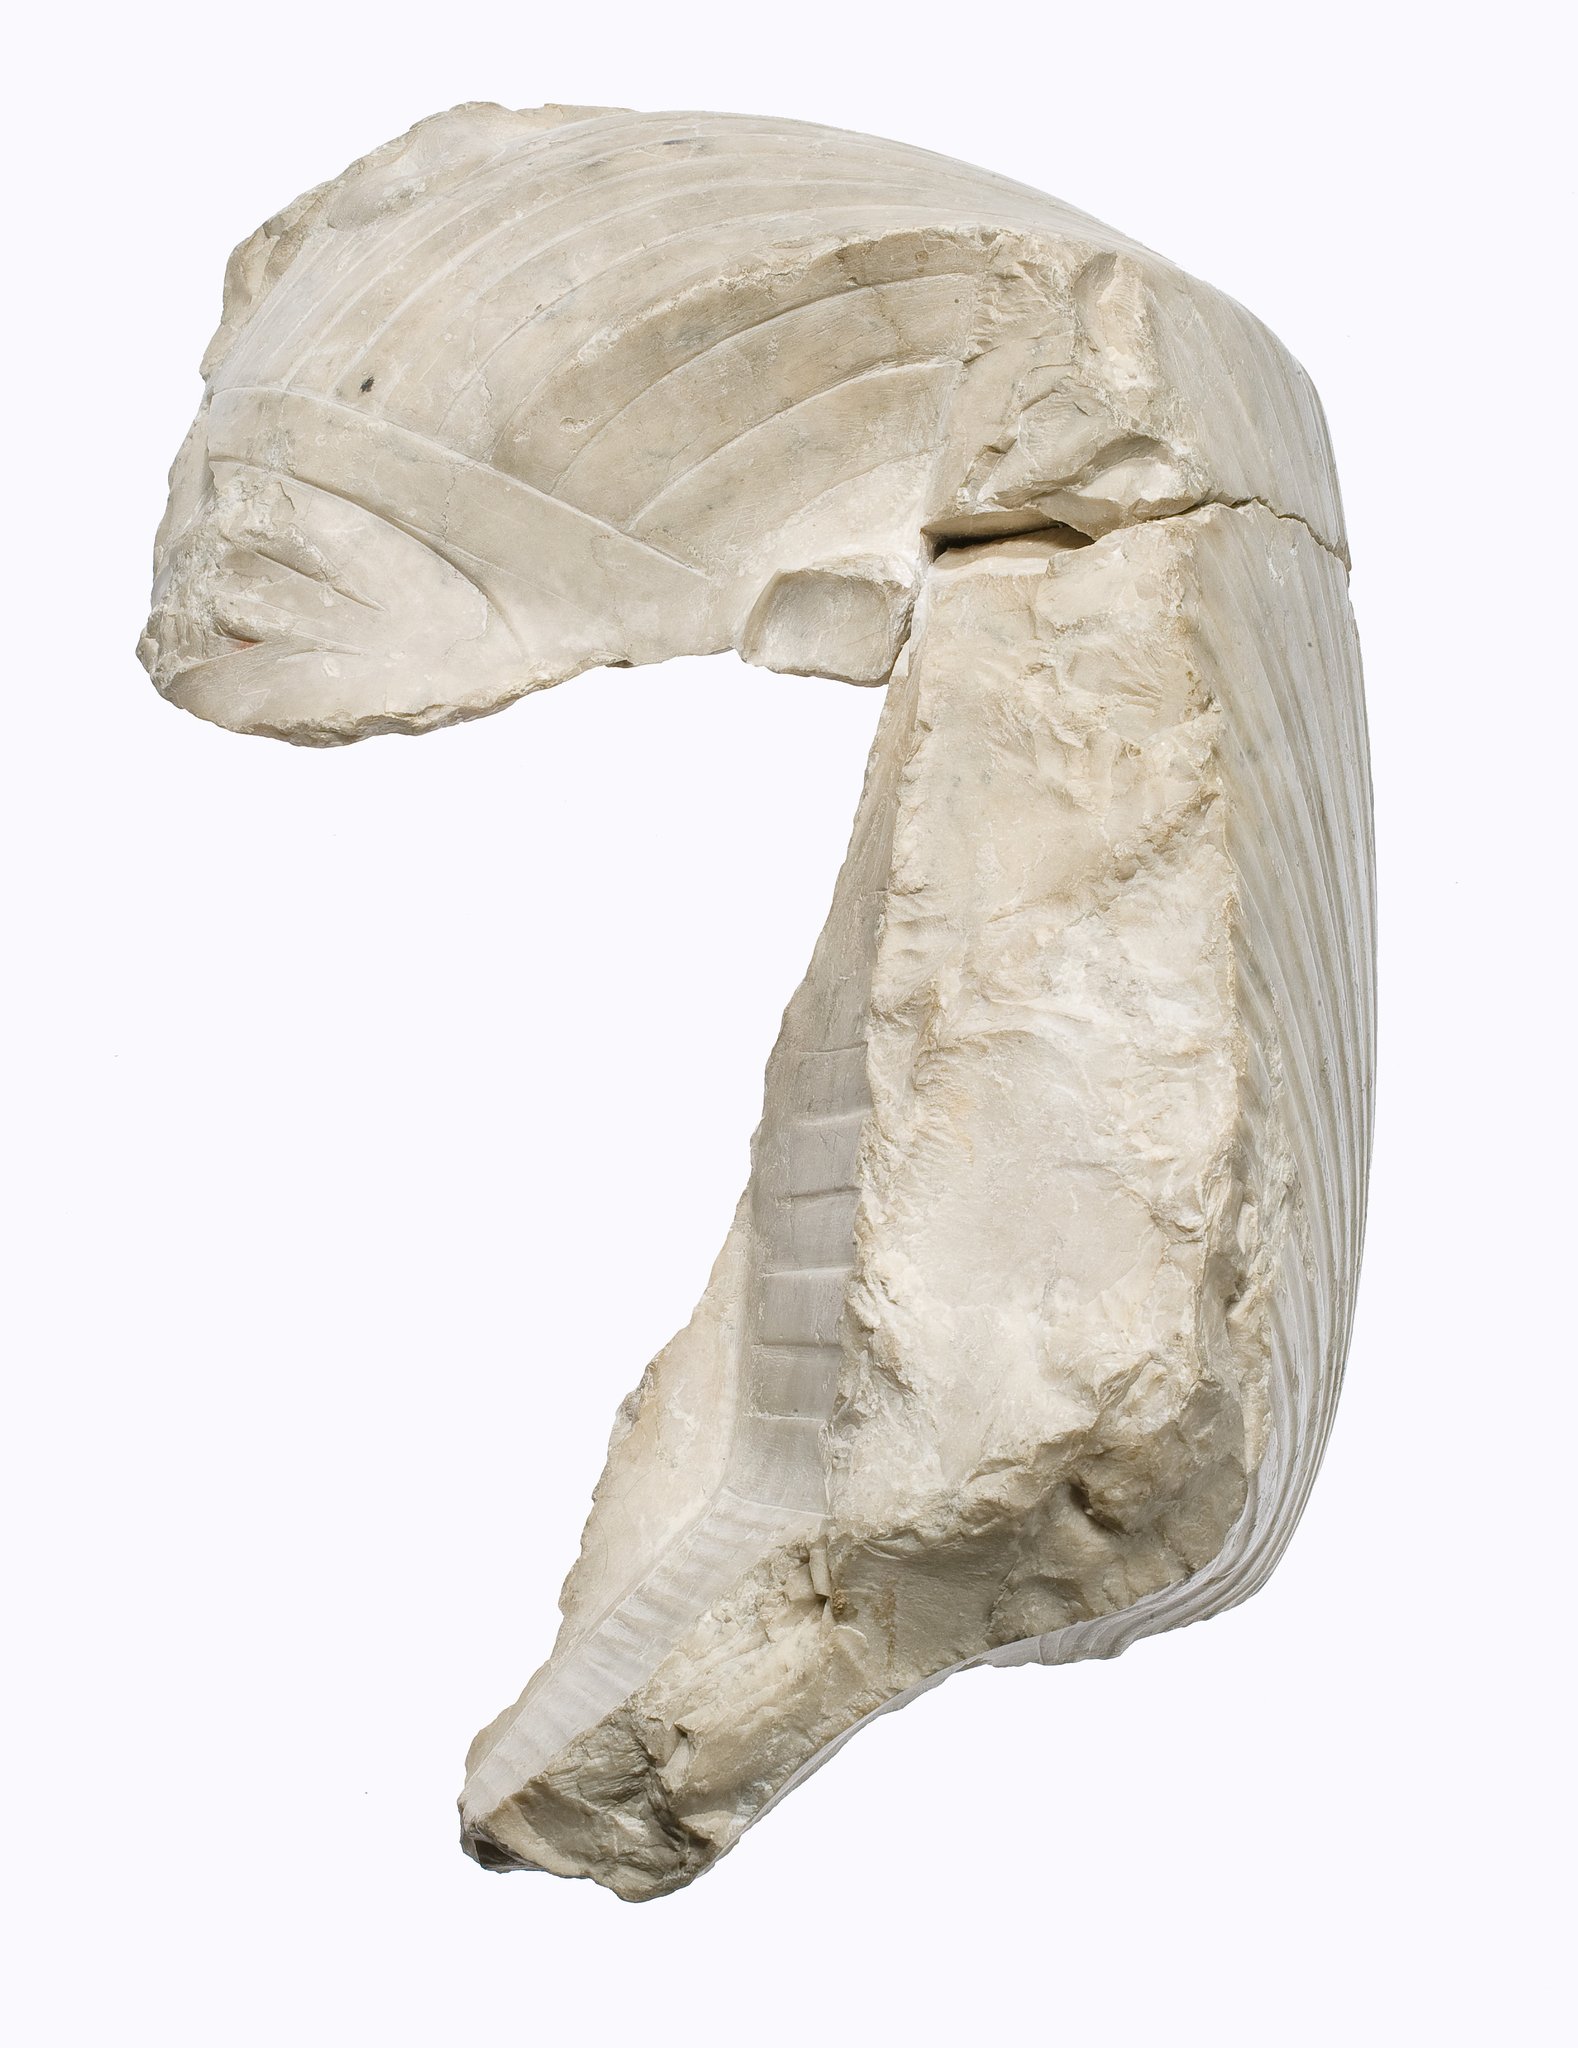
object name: head of akhenaten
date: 1353-1336 BCE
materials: limestone, paint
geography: egypt